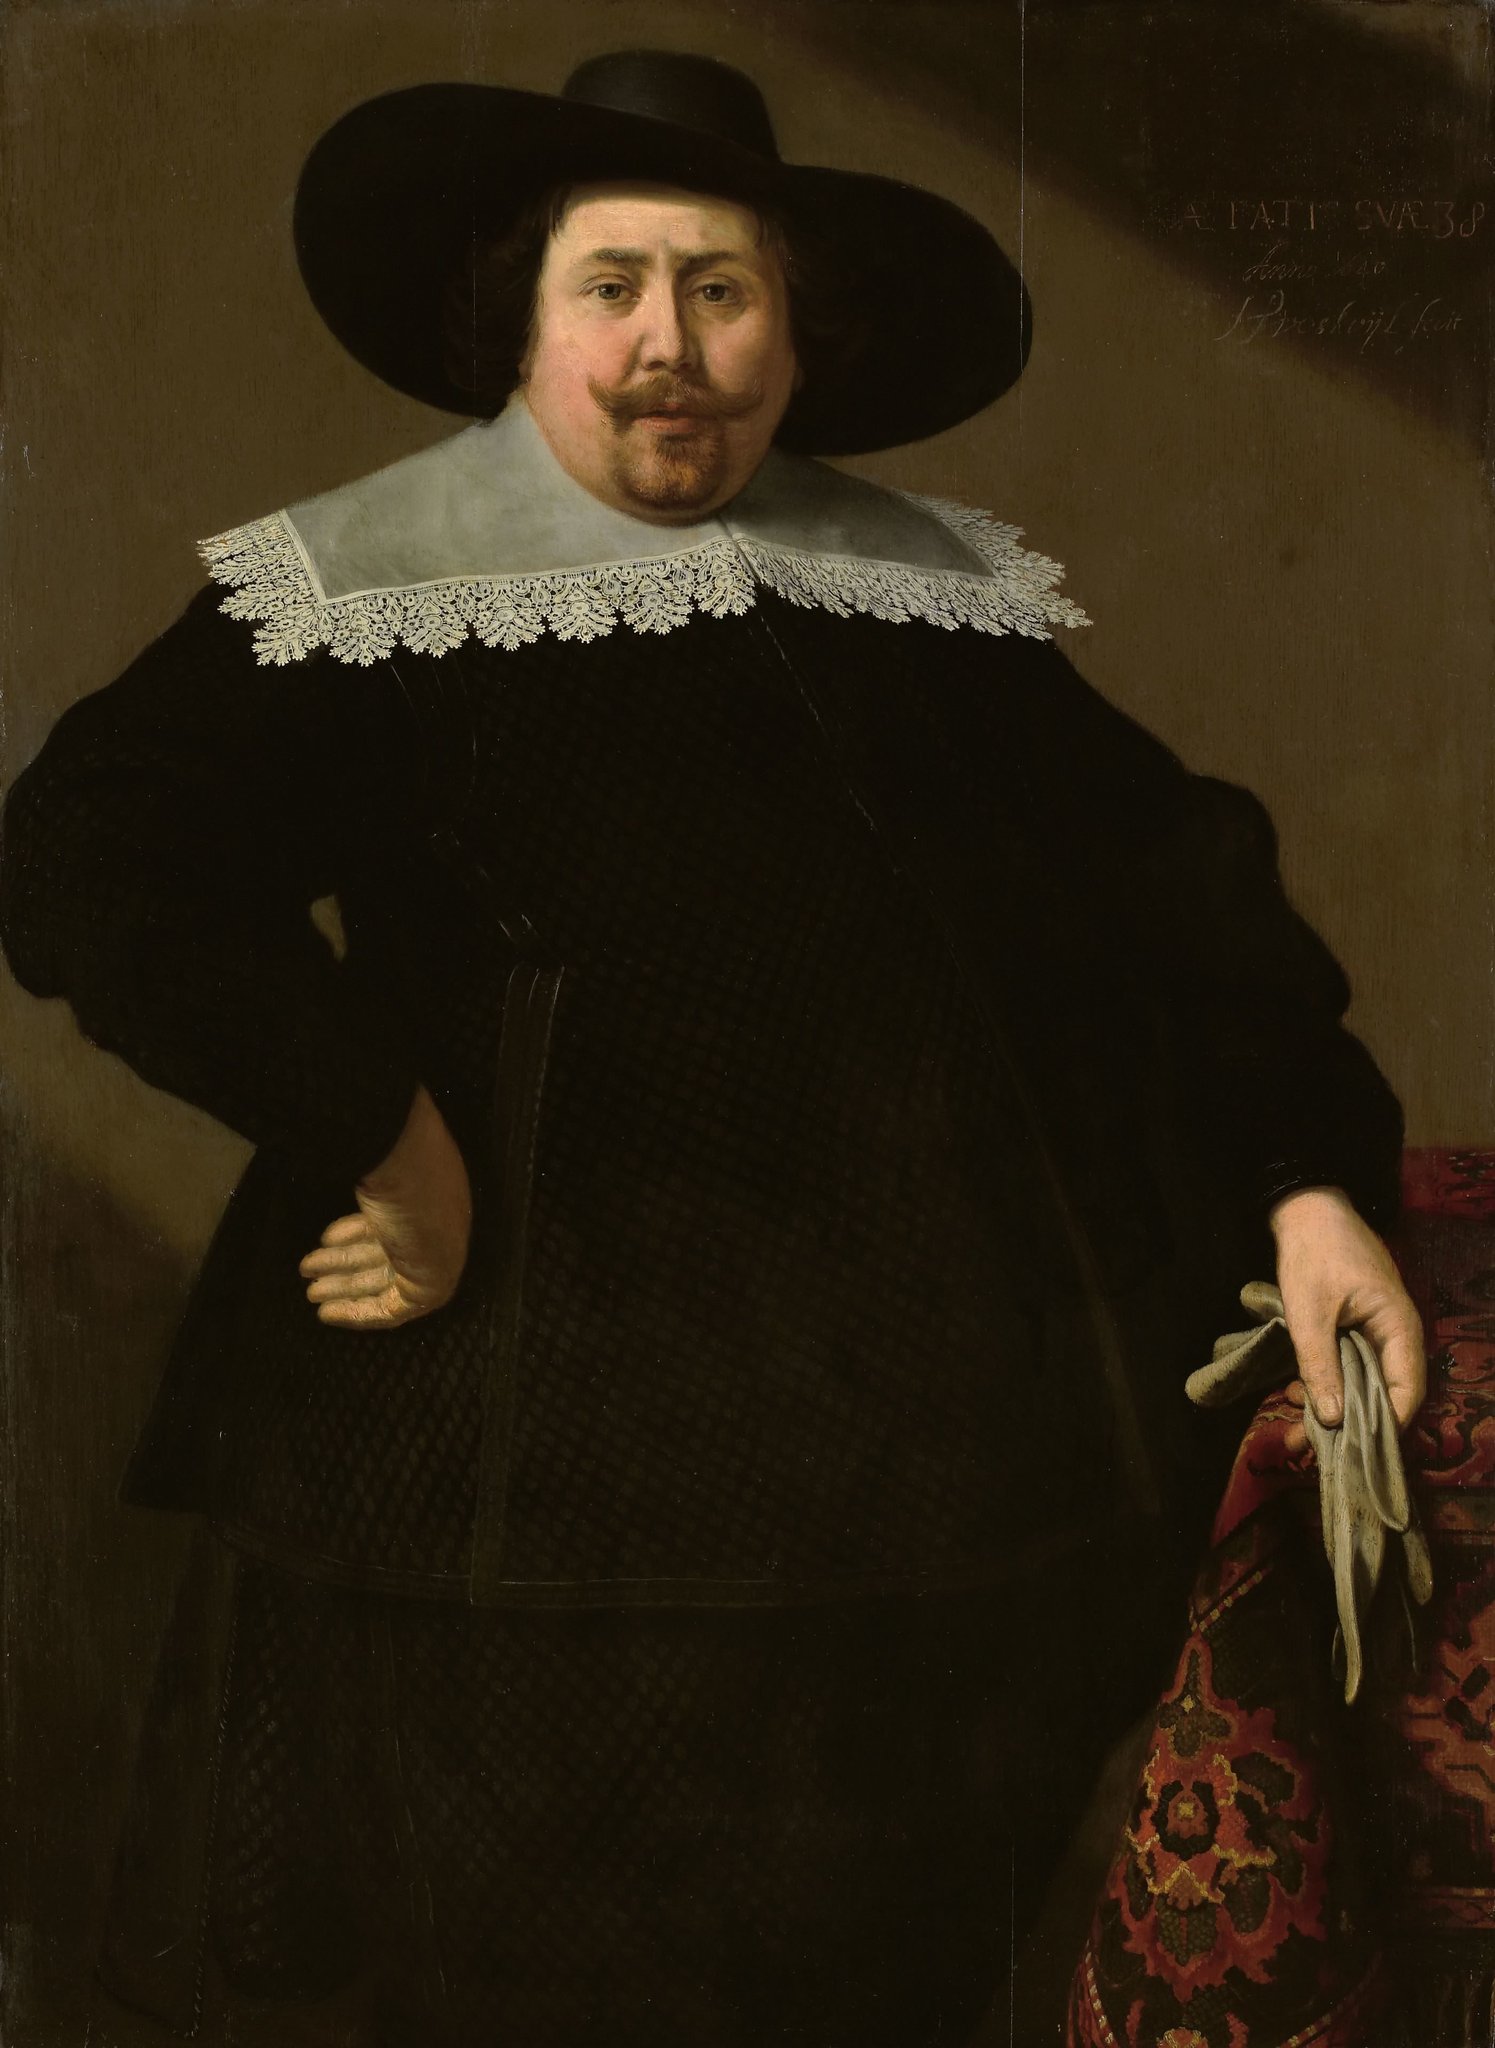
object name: painting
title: Portrait of Philips Denijs (1604-66)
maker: huygh pietersz voskuyl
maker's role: painter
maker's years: 1591-1665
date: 1640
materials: oil, panel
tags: historical persons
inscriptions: signature, date and inscription, upper right (H and P ligated): ‘ÆTATIS SVÆ38 / Anno 1640. / HP Voskuijl fecit’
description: Portret van Philips Denijs (1604-66), brouwer te Amsterdam. Kniestuk, staande bij een tafel, met de rechterhand in de zij en handschoenen in de linkerhand. Pendant van SK-A-2369.